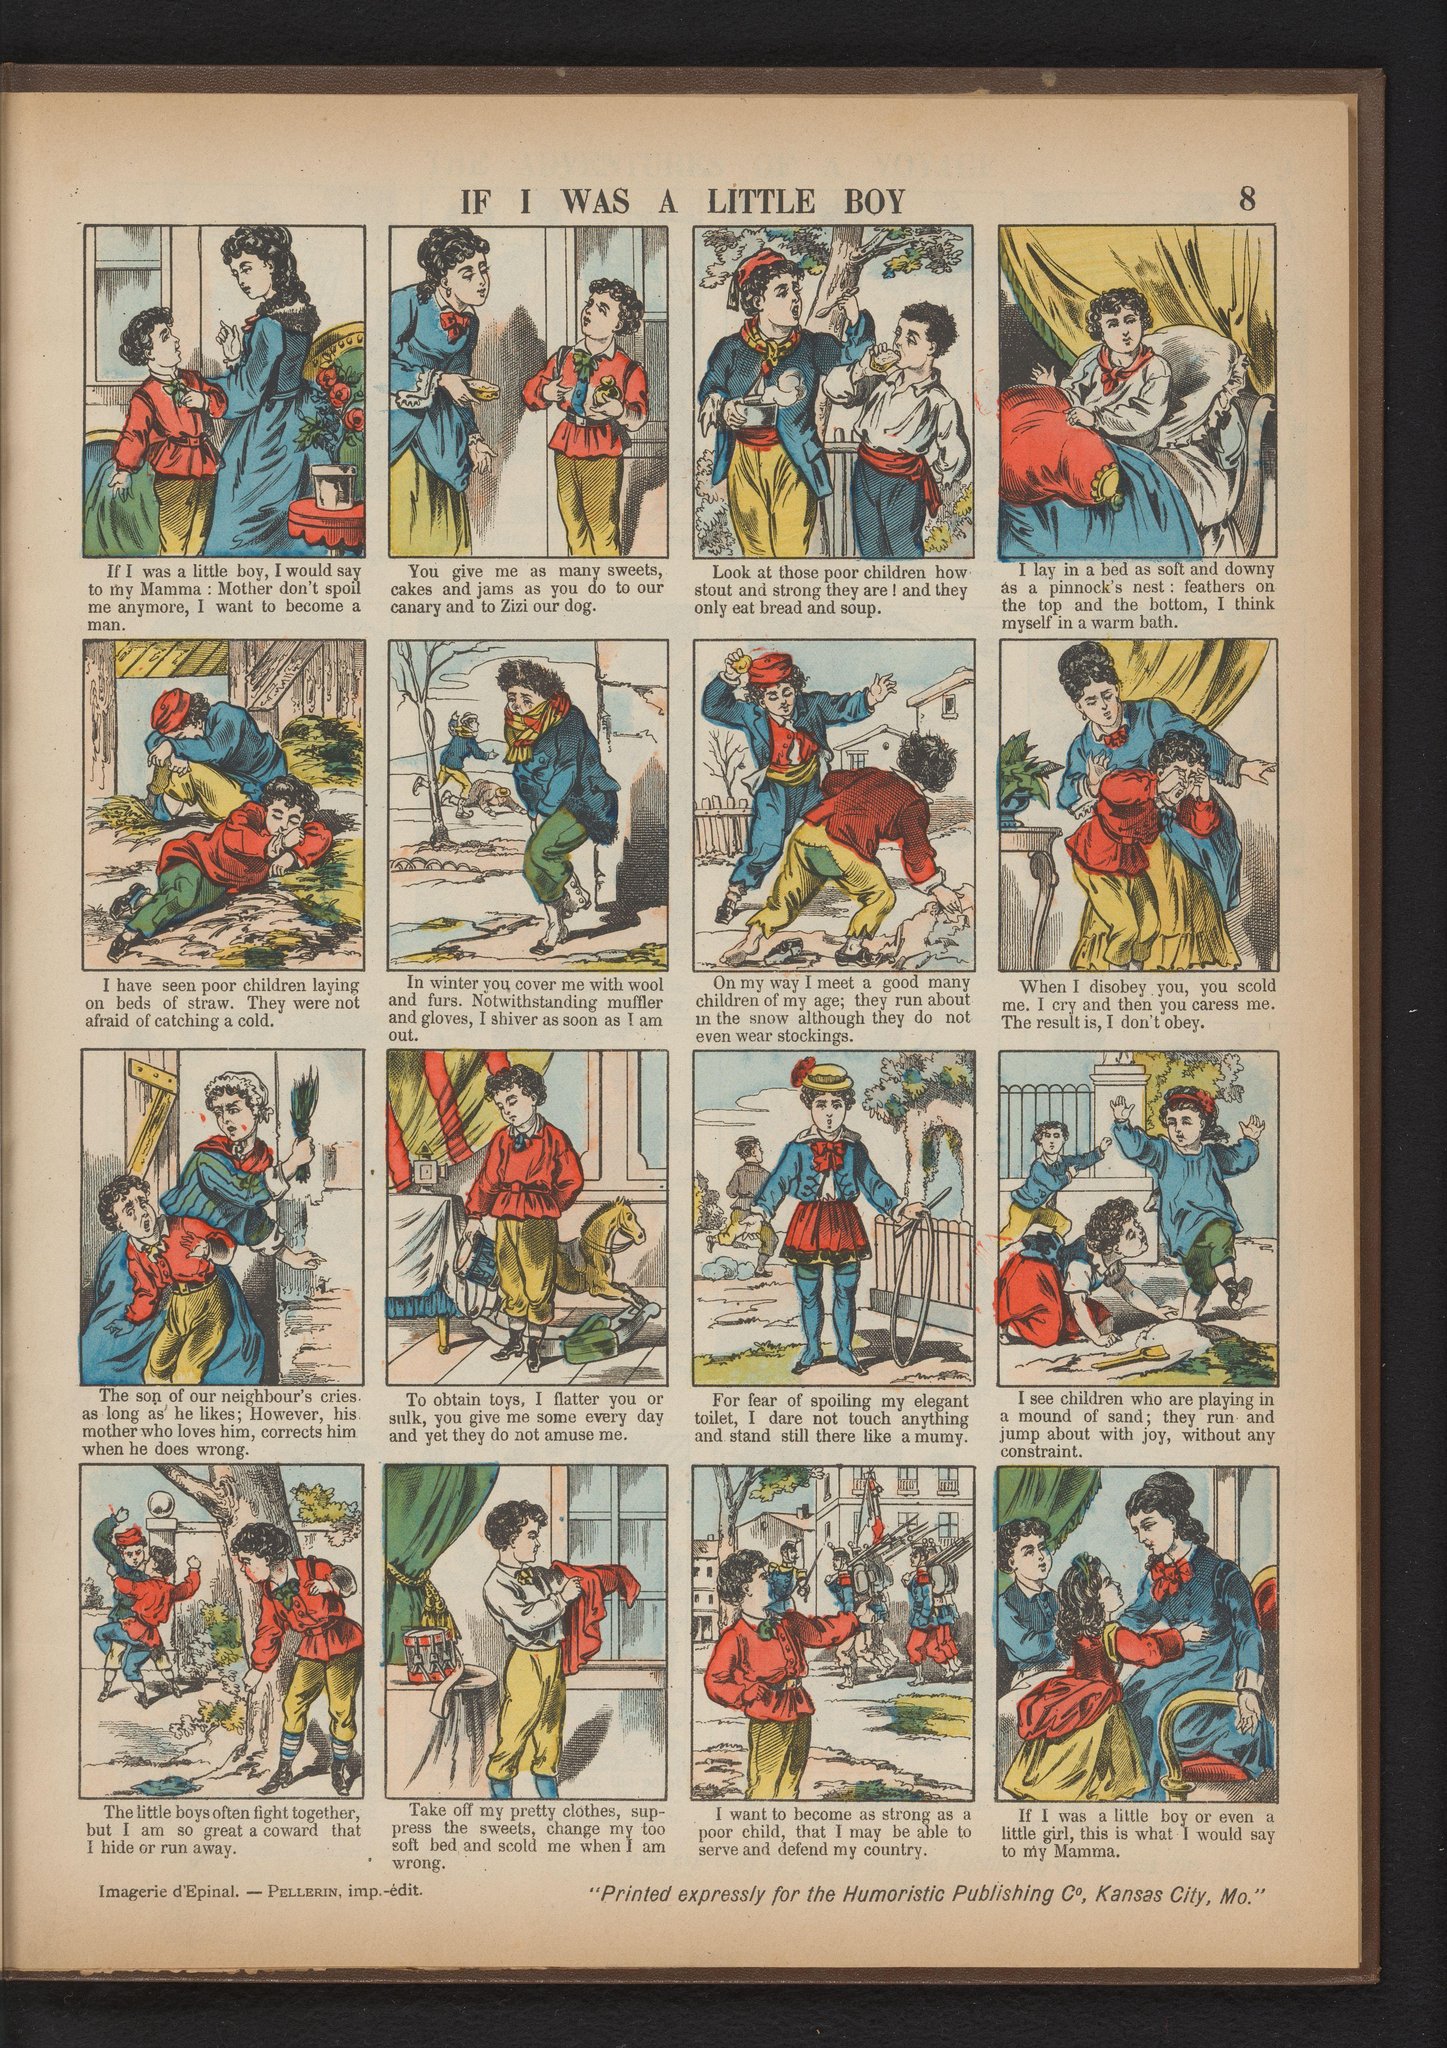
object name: print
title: Sprookjes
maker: Anonymous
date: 1893-1894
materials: paper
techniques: colour, letterpress printing, lithograph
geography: epinal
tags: boy (child between toddler and youth), poor and rich kitchen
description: Blad met zestien voorstellingen over een jongen die niet langer verwend wil worden, maar sterk en stoer wil zijn, net als de arme kinderen. Onder elke voorstelling een onderschrift in het Engels. Deze prent maakt deel uit van een album.